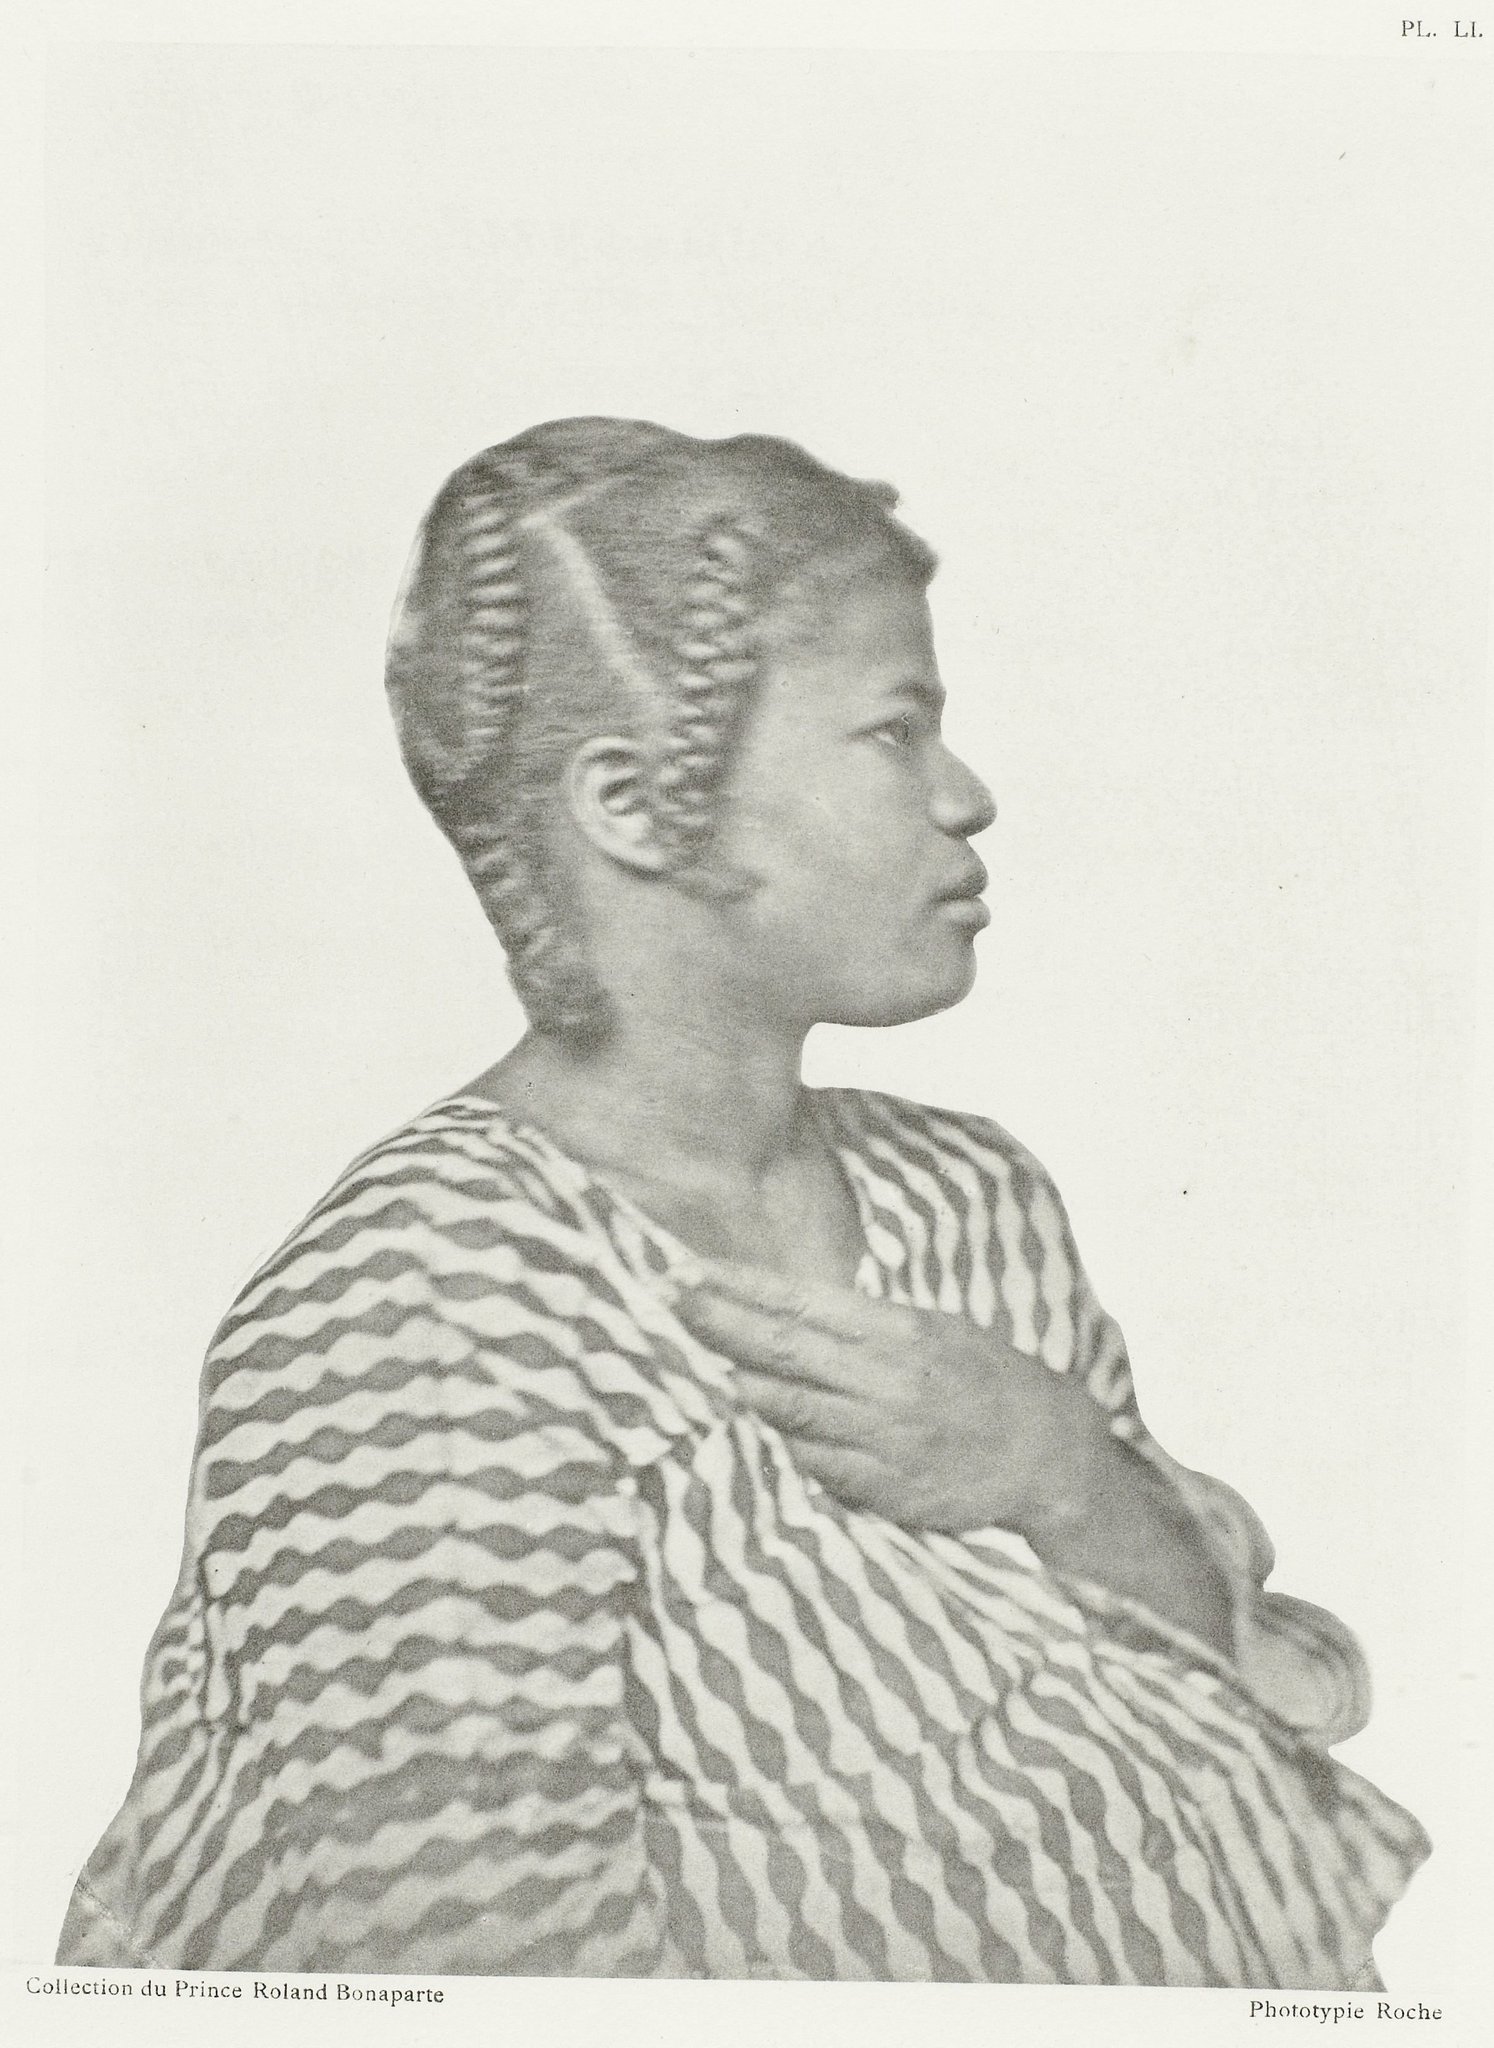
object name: photomechanical print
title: Portret van Amalia Fri-Mason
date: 1883-1884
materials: paper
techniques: photograph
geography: amsterdam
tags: adult woman, historical persons, amsterdam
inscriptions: inscription: ‘Collection du Prince Roland Bonaparte/ Phototypie Roche’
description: Portret van Amalia Fri-Mason, een Surinaamse vrouw van Afrikaanse en Europese oorsprong, gefotografeerd op de Internationale Koloniale en Uitvoerhandel Tentoonstelling, Amsterdam 1883.